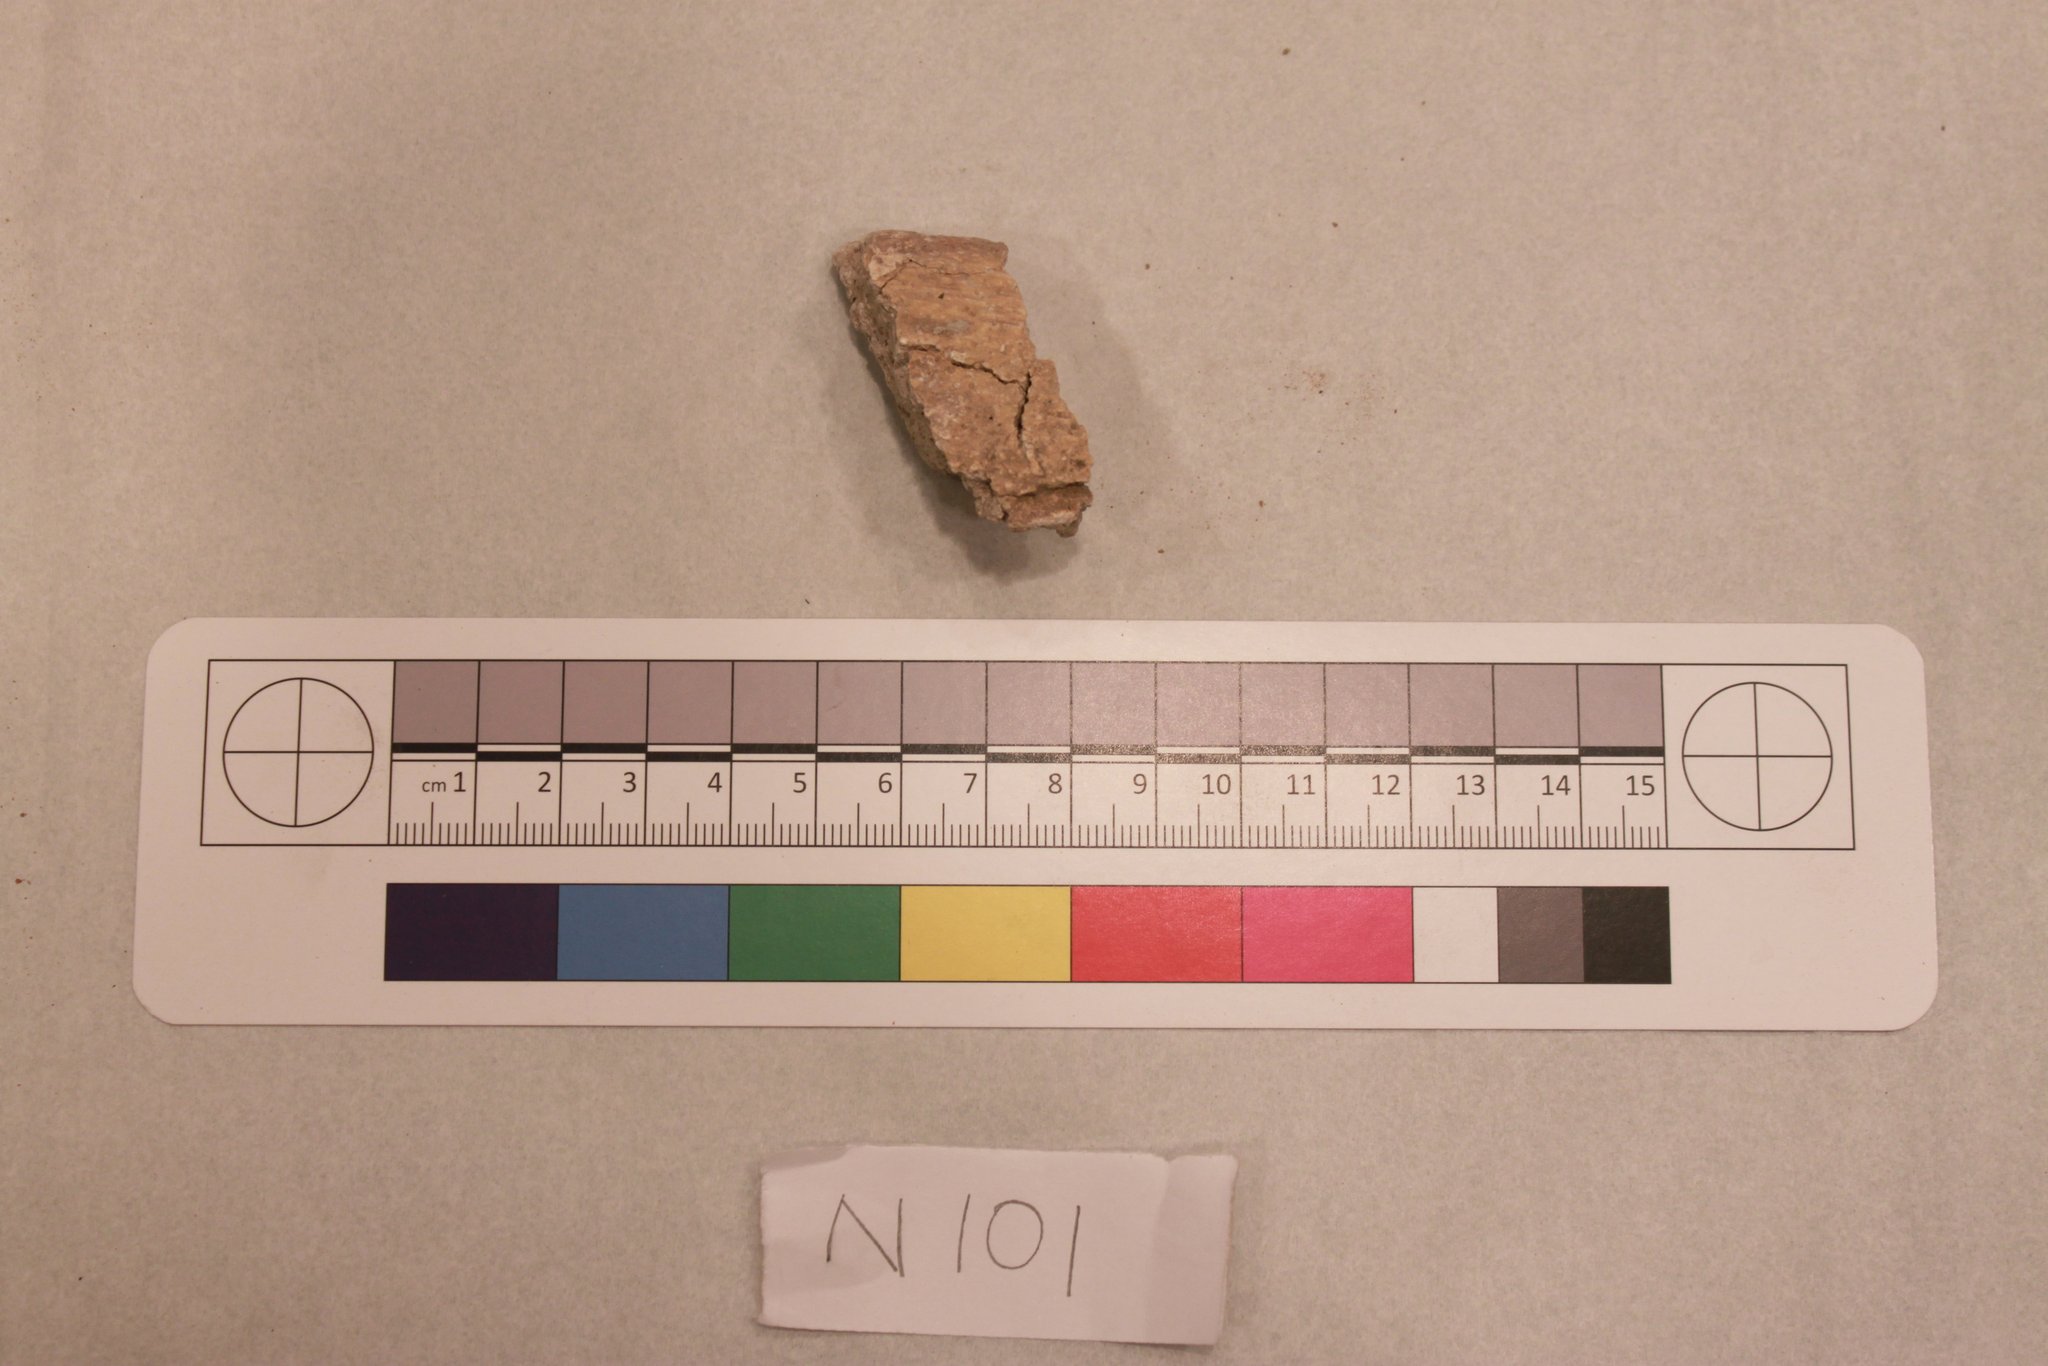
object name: fragment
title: Stucco Fragment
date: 701-1200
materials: plaster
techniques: carving, painting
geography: iran